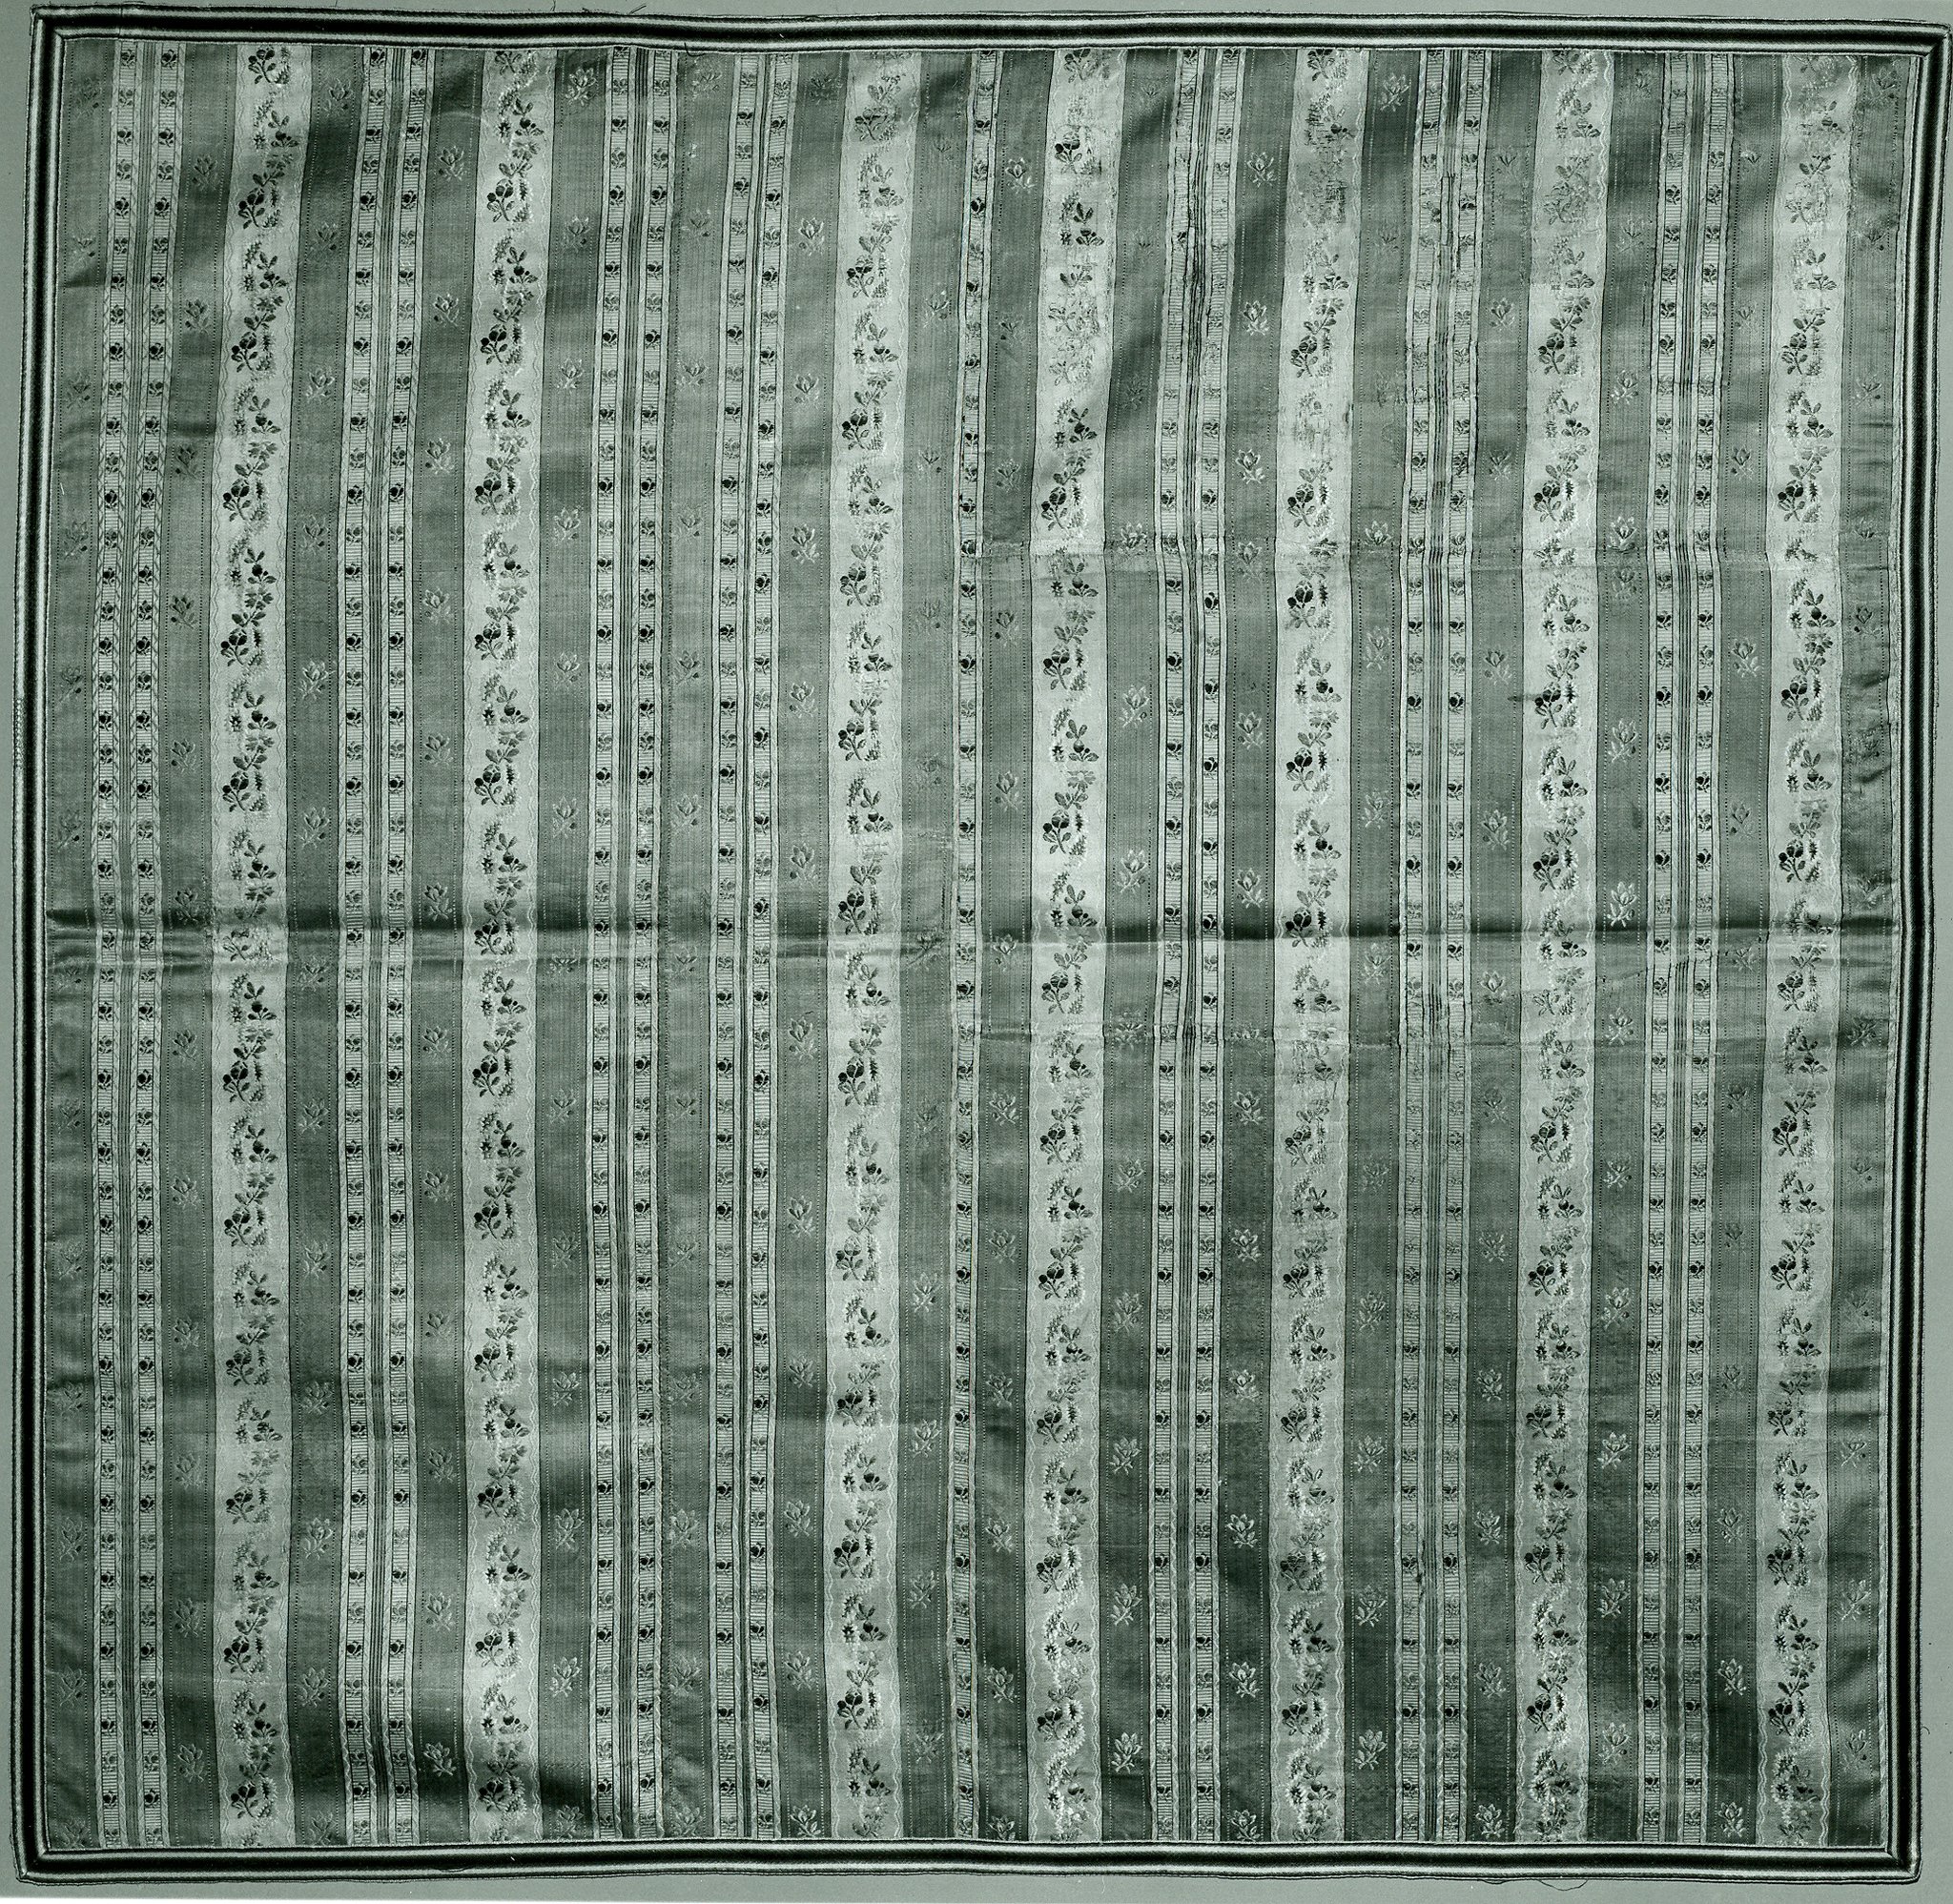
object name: textile cover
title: Cover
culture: spanish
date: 1767-1800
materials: cotton, silk